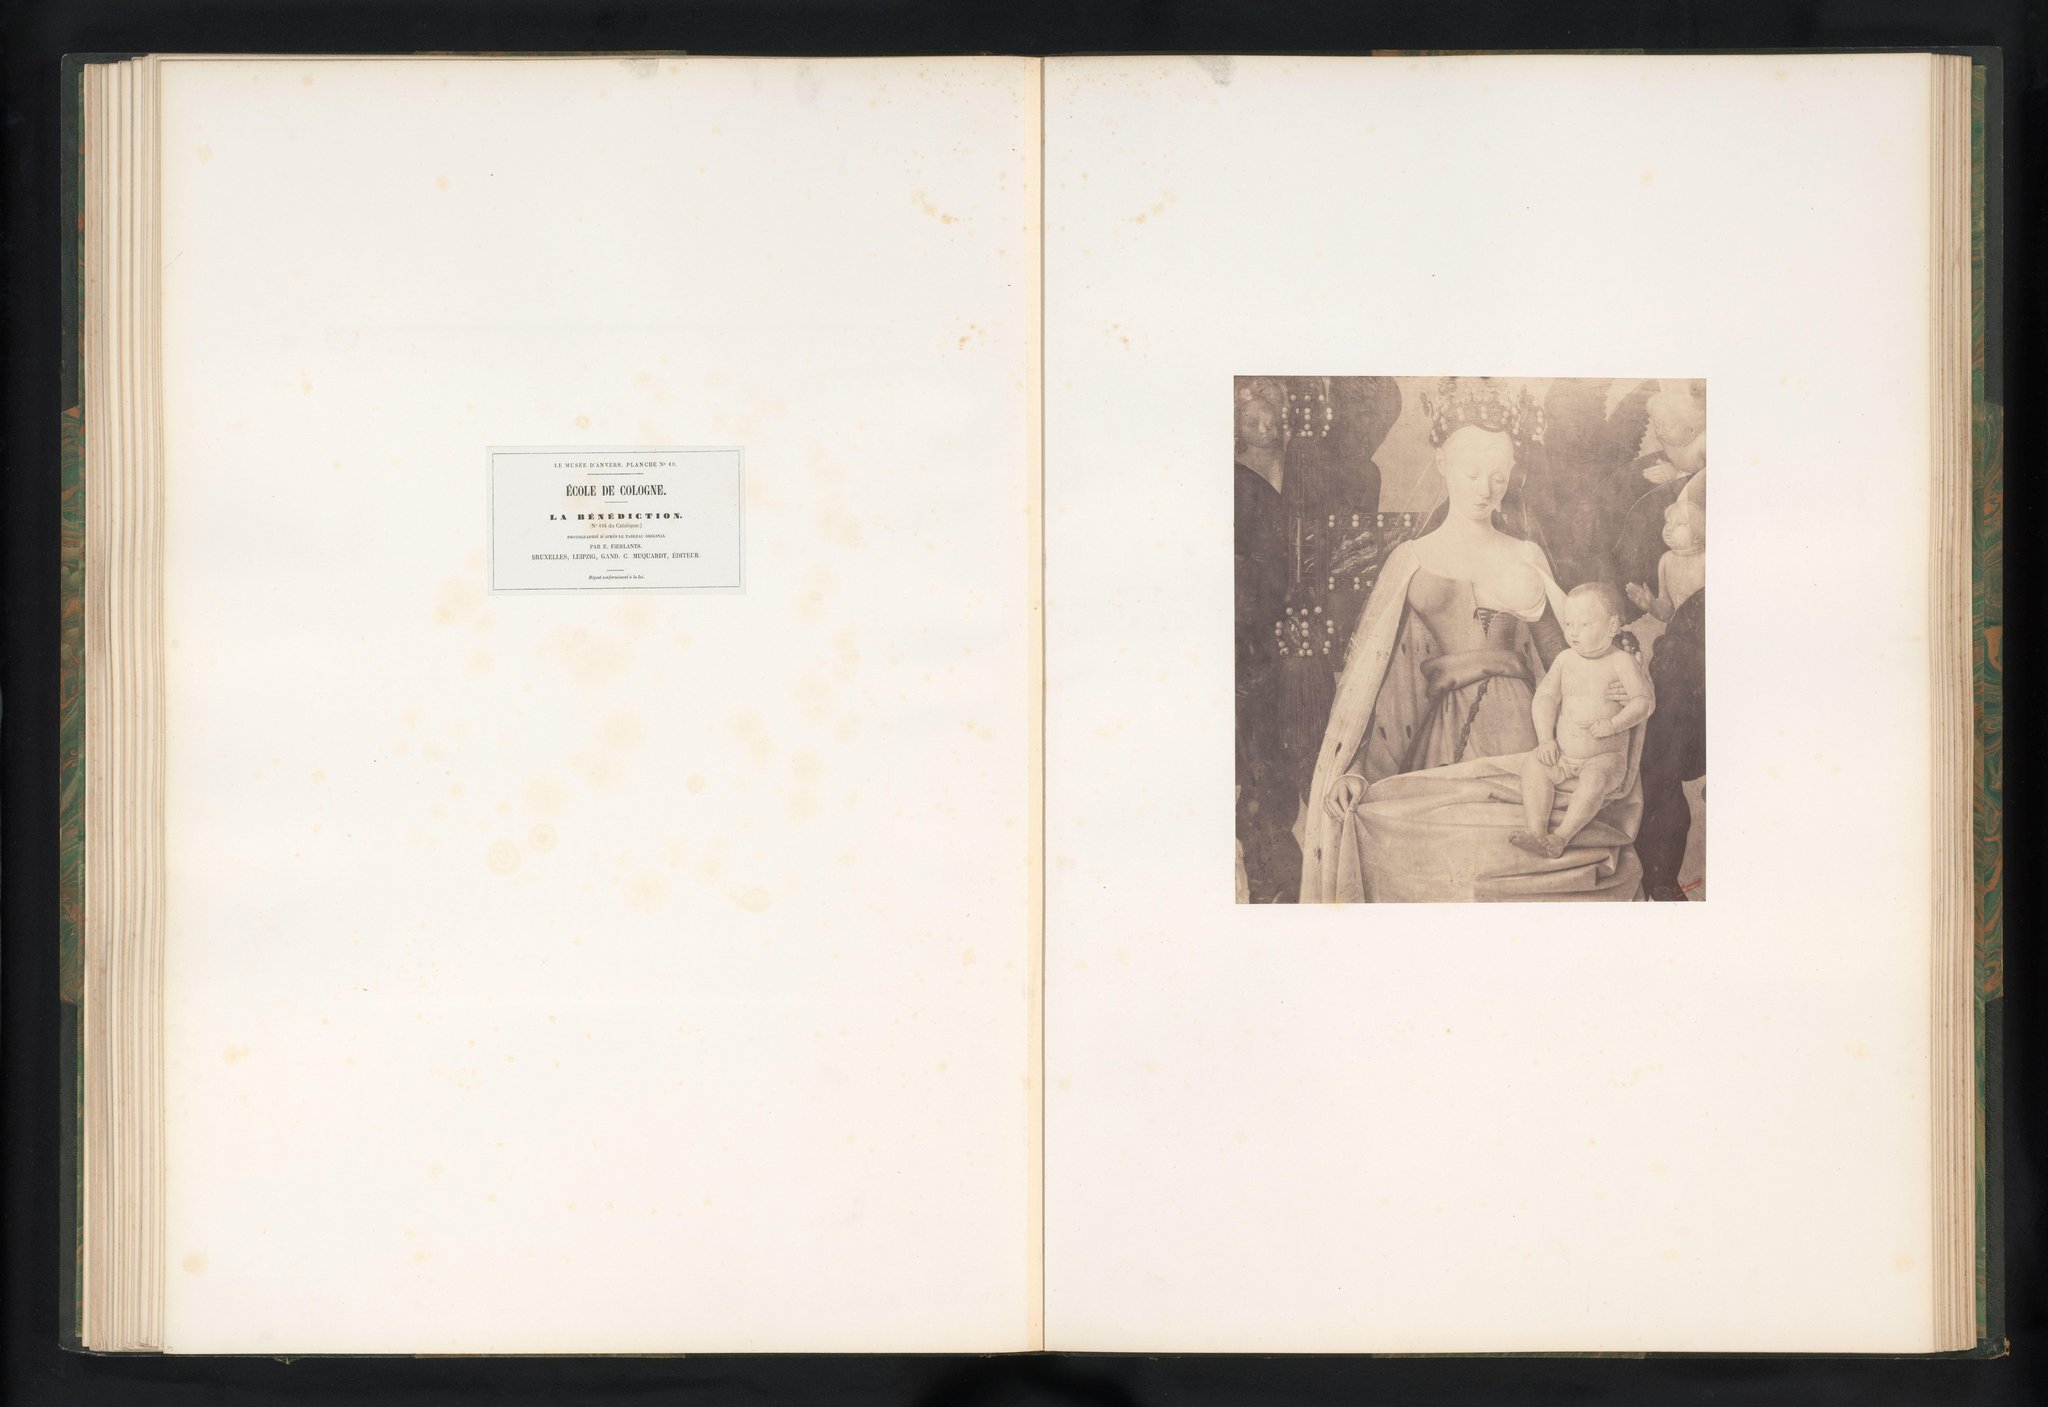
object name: reproduction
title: Fotoreproductie van Maria omringd door serafijnen en cherubijnen door Jean Fouquet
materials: photographic support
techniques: albumen print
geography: brussels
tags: mary sitting or enthroned, the christ-child sitting on her knee (christ-child to mary's left)